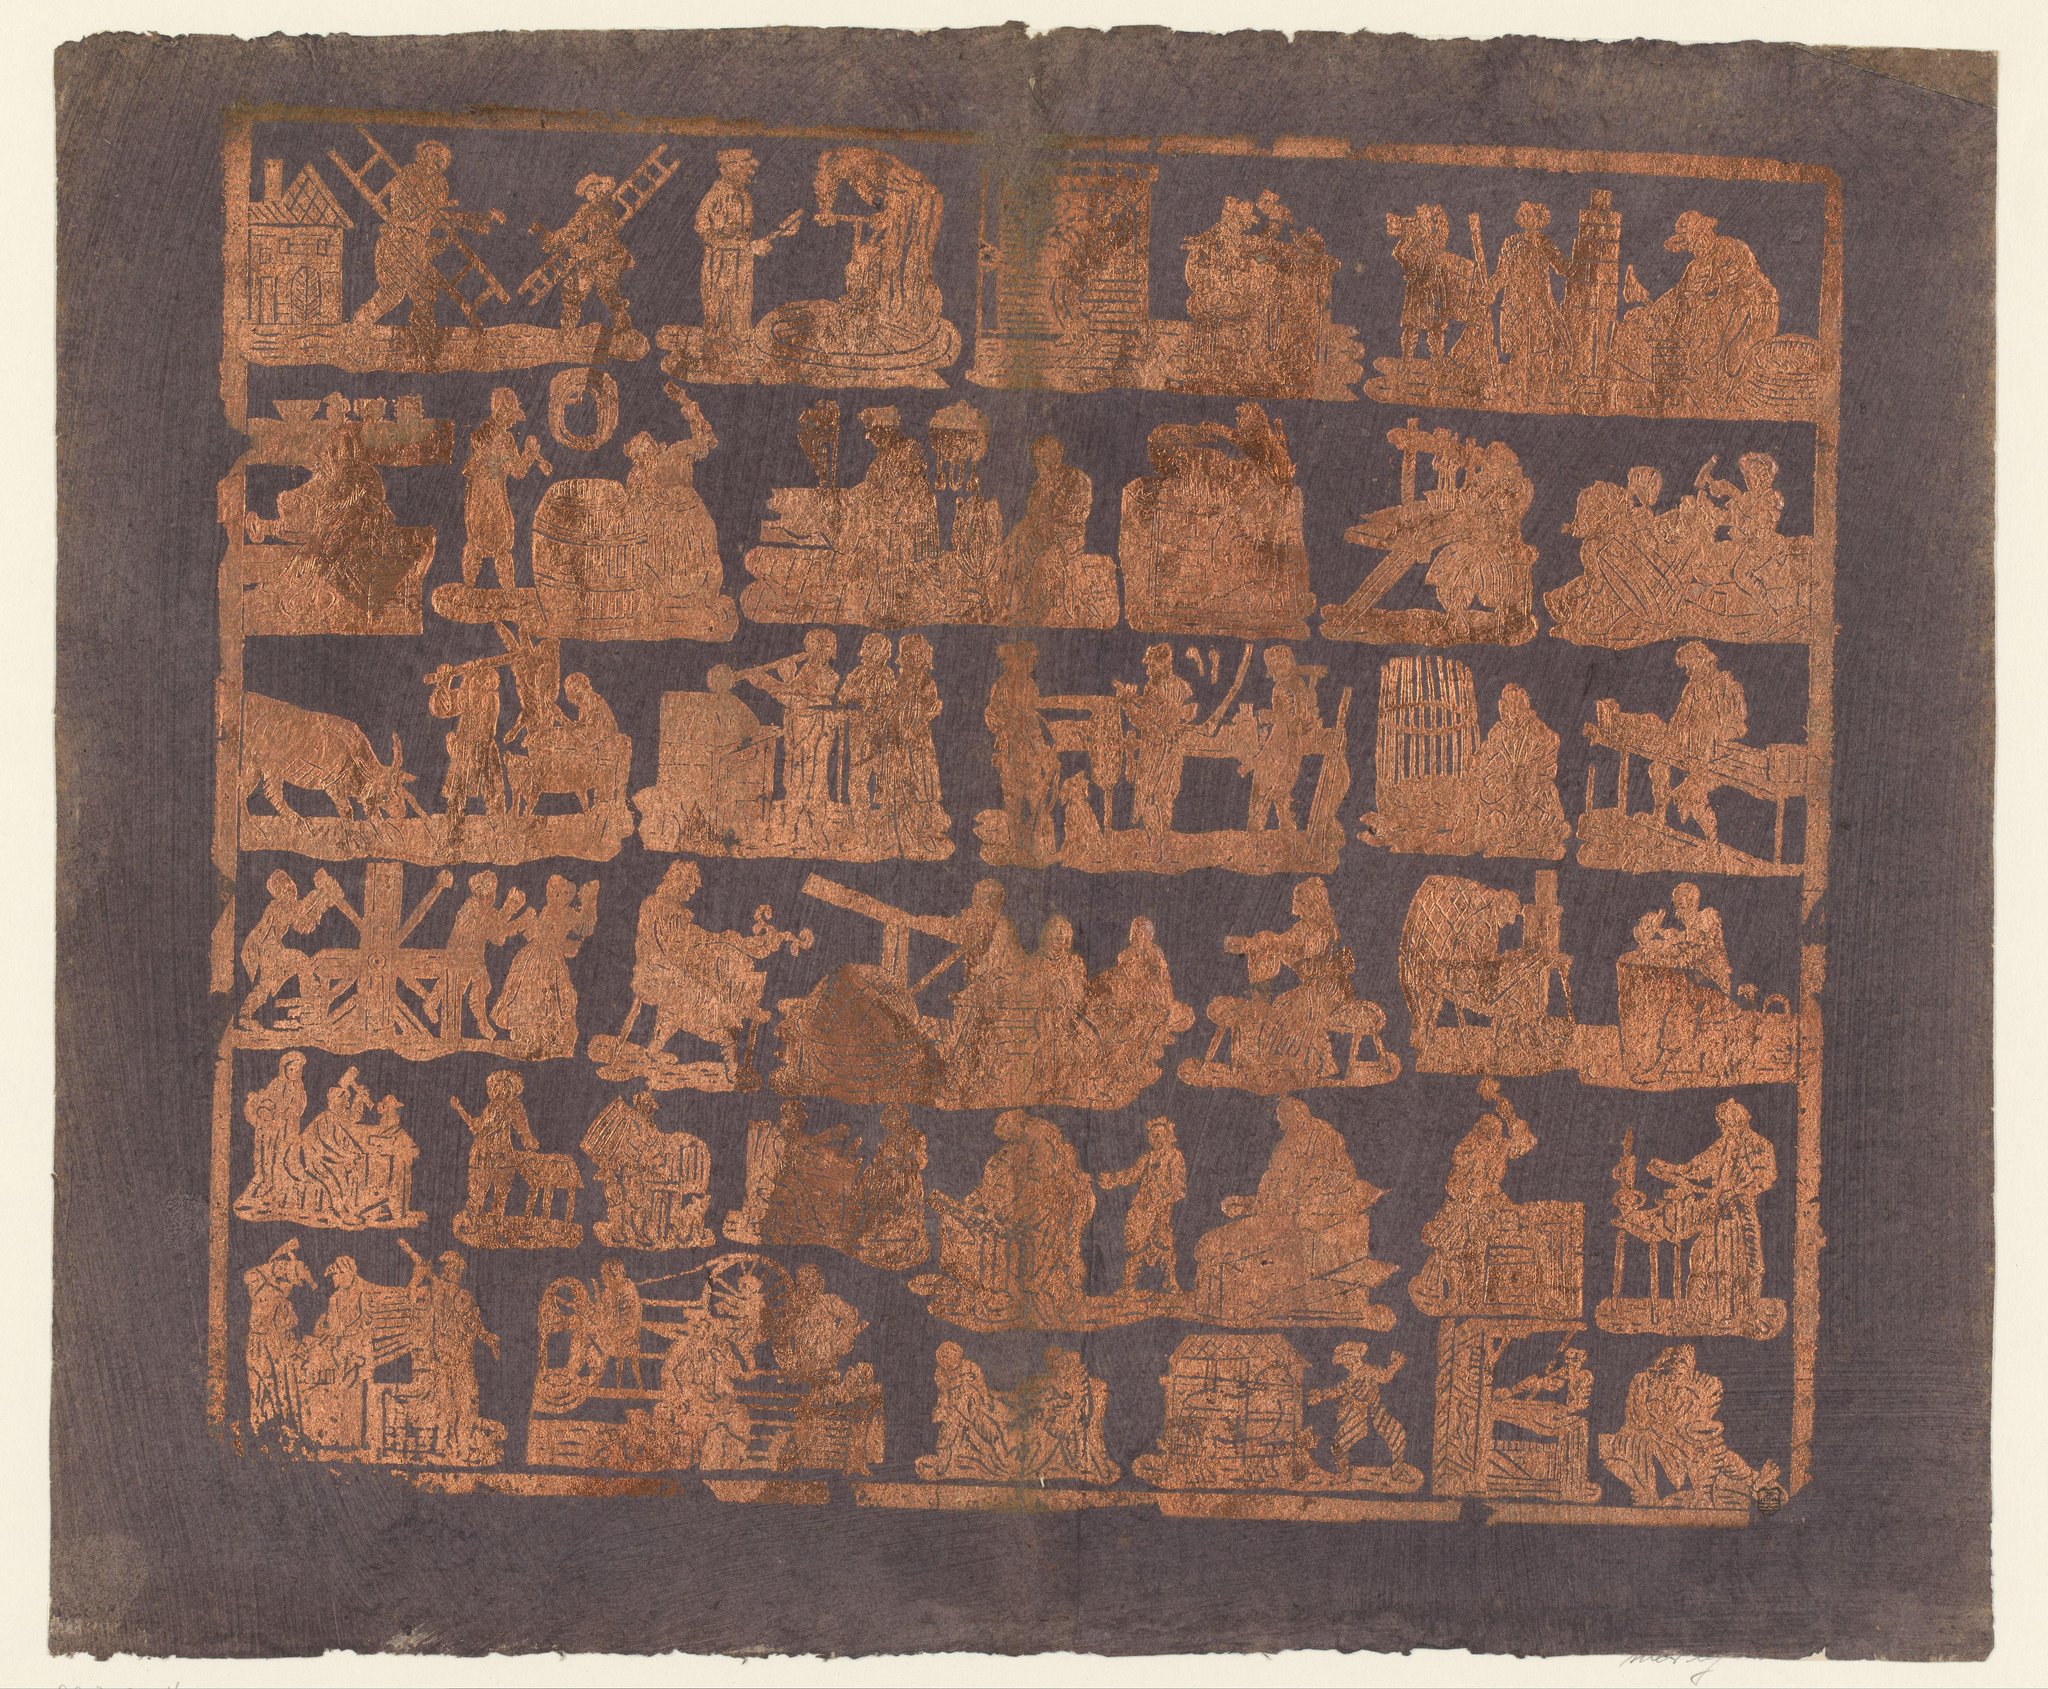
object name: brocade paper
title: Blad met beroepen in zes rijen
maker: Anonymous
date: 1750-1800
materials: gold leaf, paint, paper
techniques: relief print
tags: handicrafts ~ maintenance and repair, mason at work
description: Blad met beroepen in zes rijen; linksboven twee mannen met ladders (schoorsteenvegers?), rechtsboven metselaar, linksonder smid, rechtsonder pottenbakker.